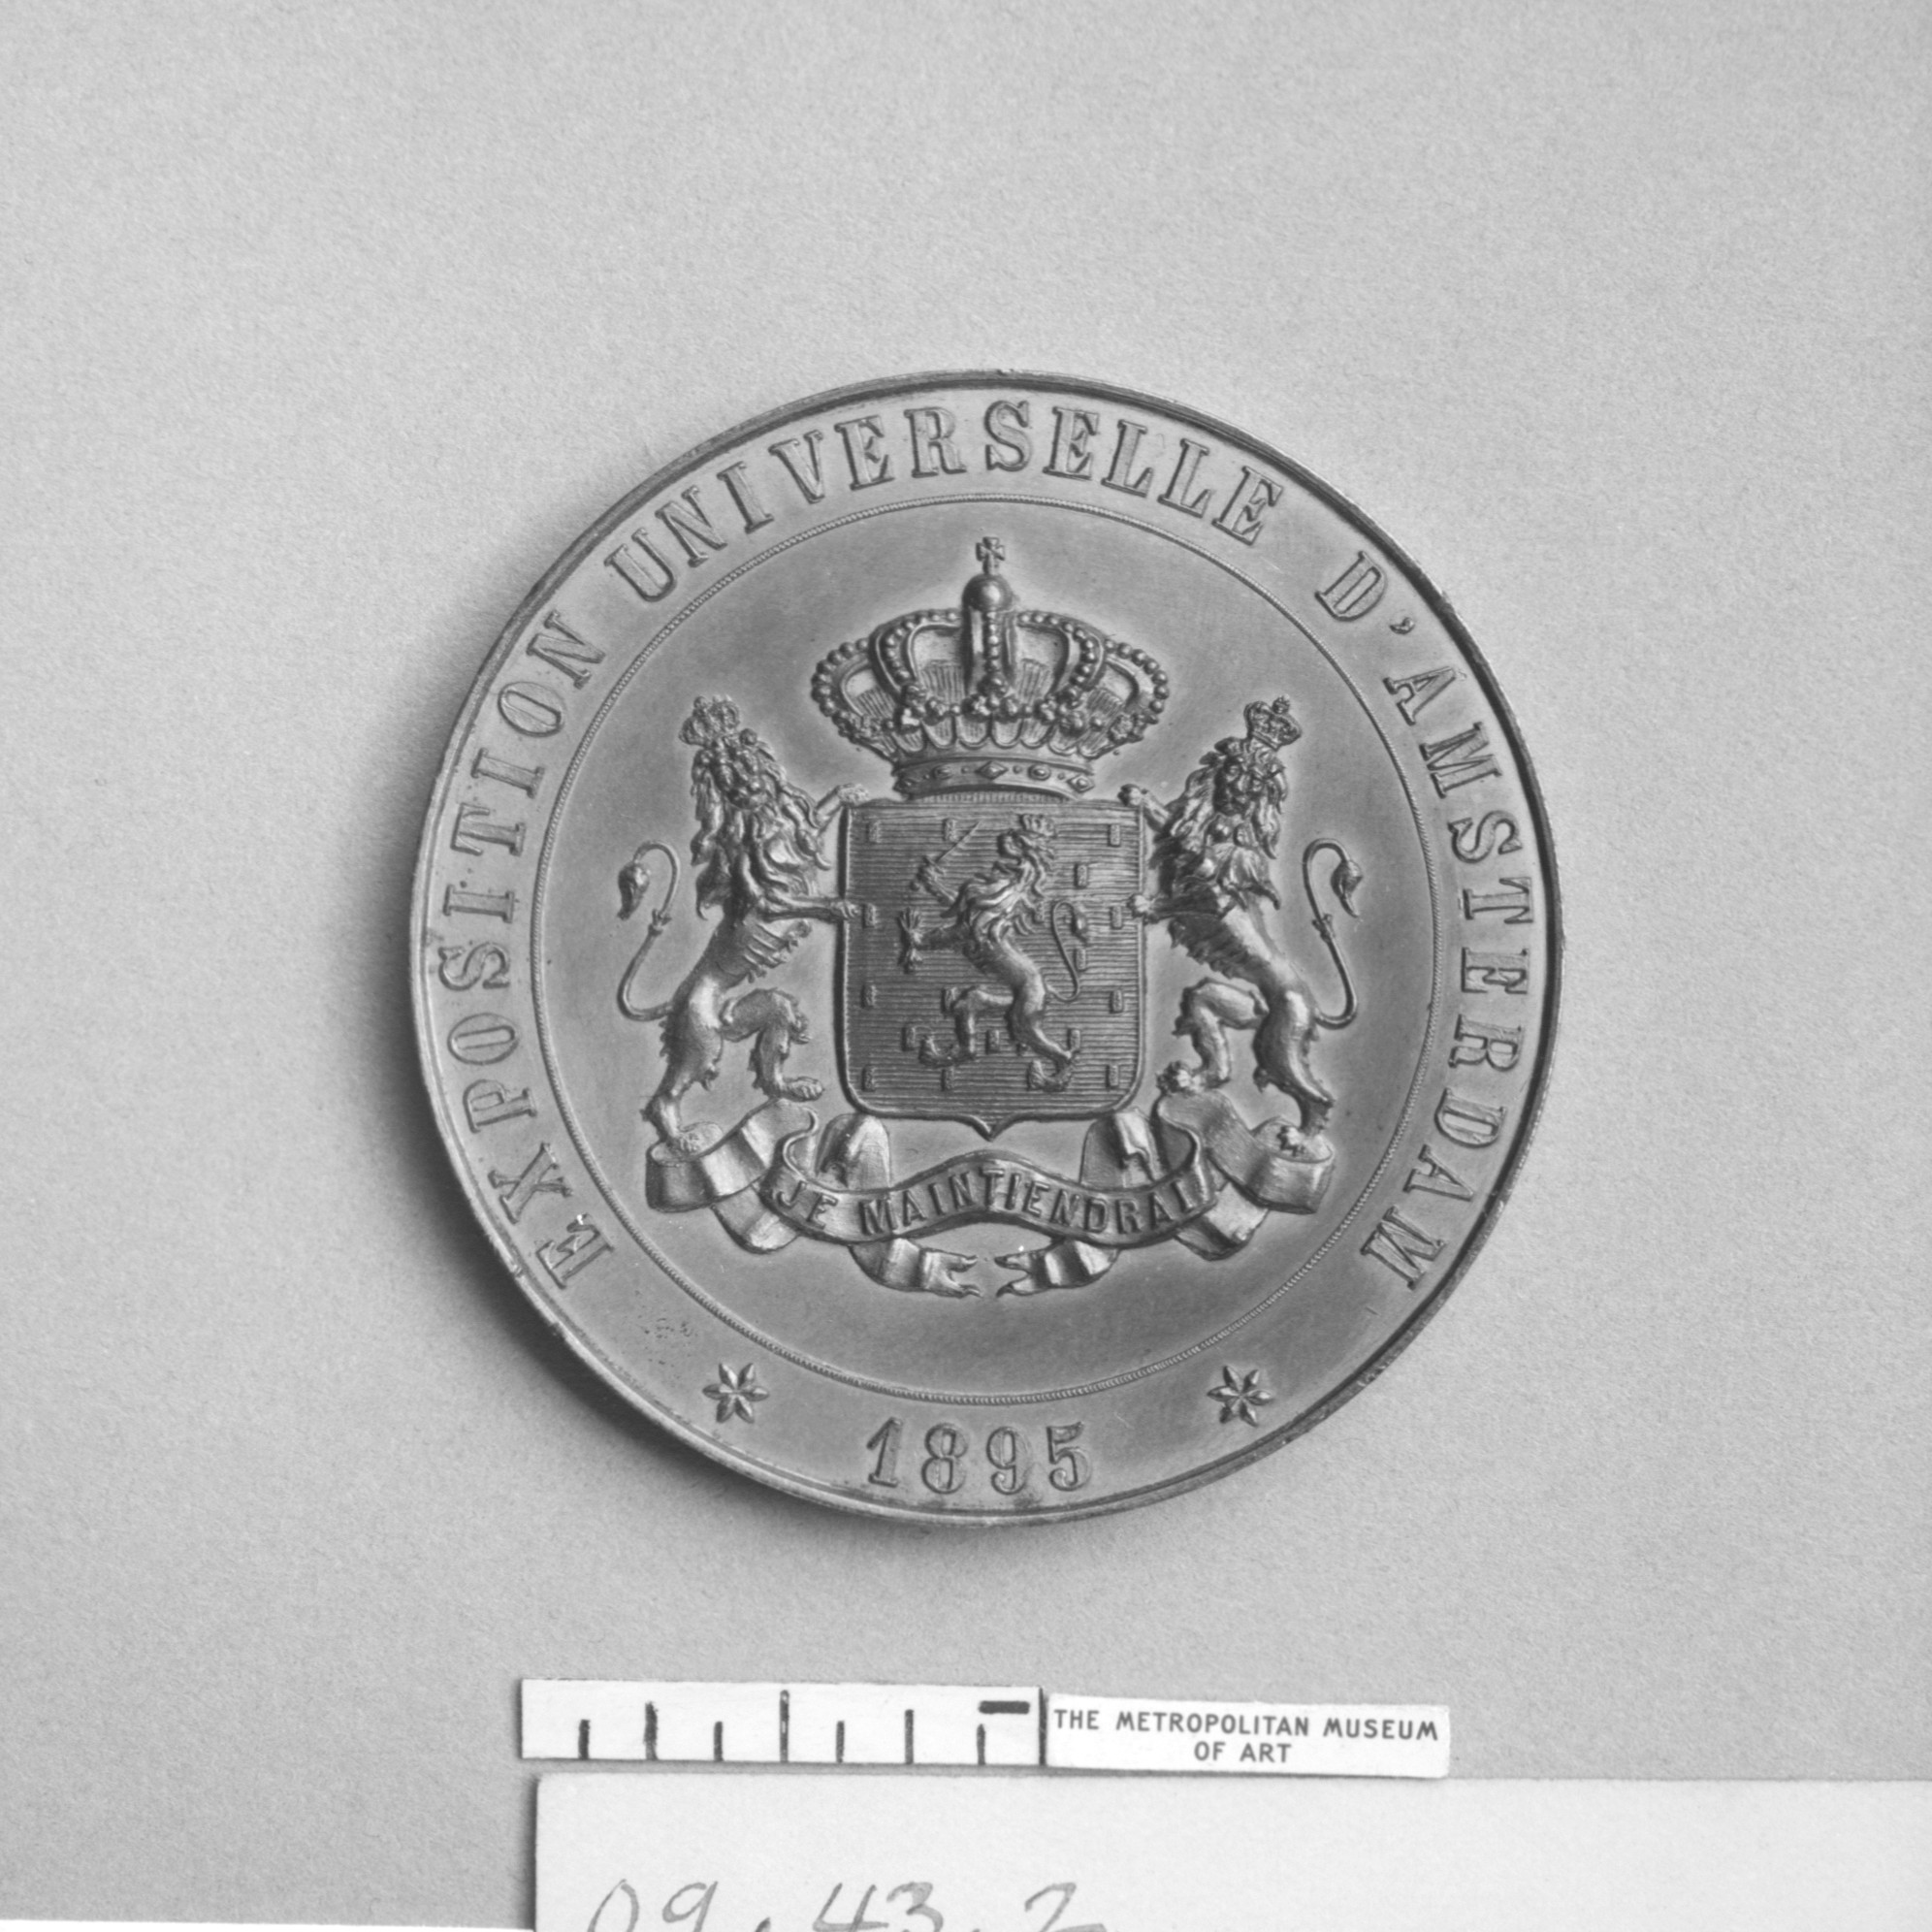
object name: medal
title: Commemorating the Universal Exhibition at Amsterdam, 1895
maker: j. m.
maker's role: artist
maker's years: 1850-1950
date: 1895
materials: gilt copper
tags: animals,coat of arms